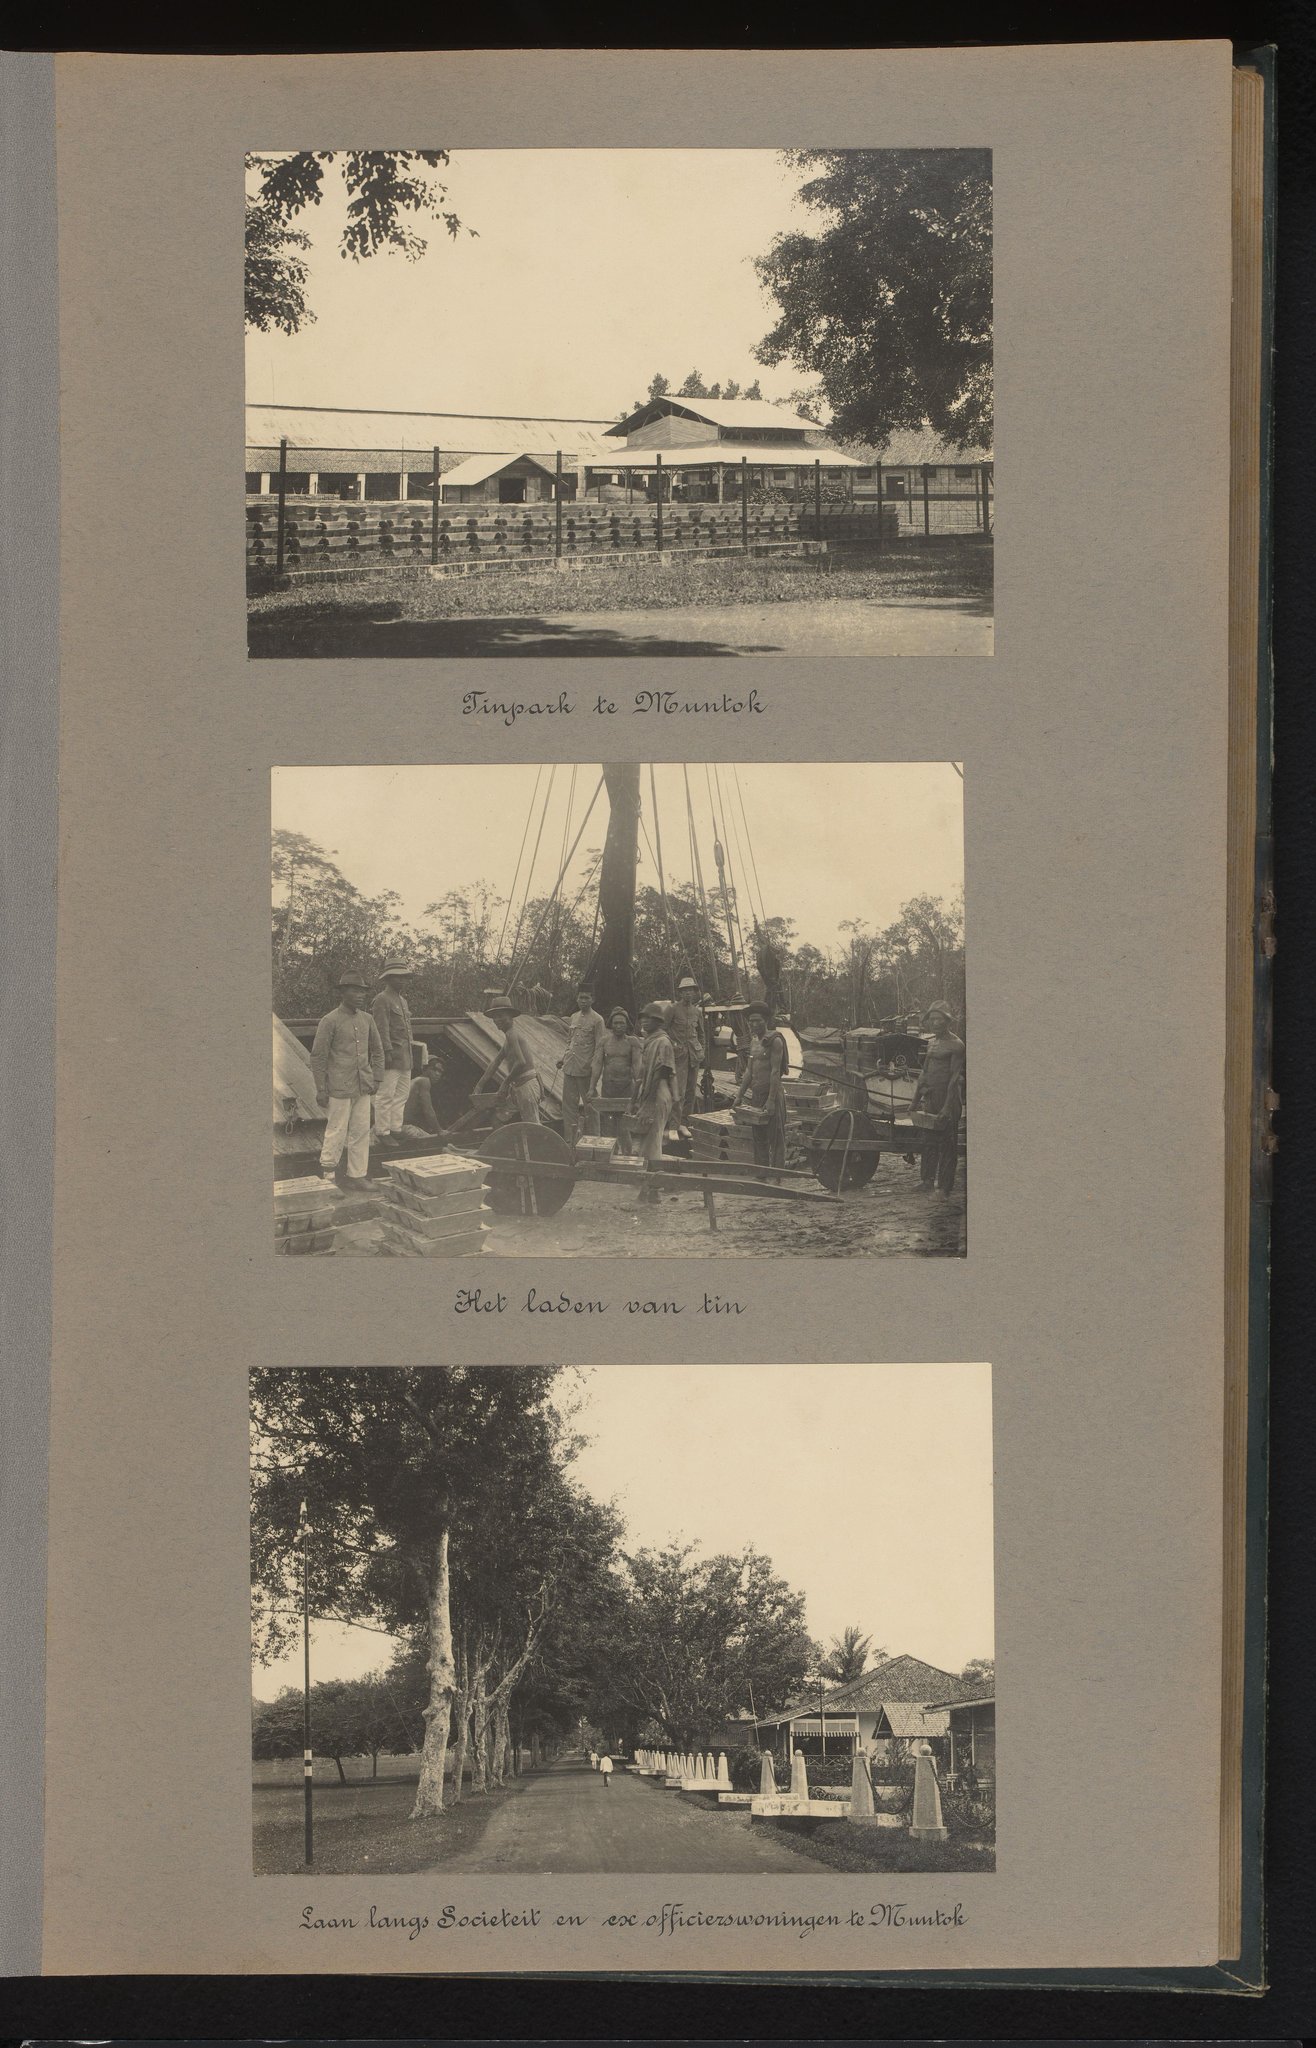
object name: photograph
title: Gebouwen en werk van de Banka-tinwinning, te Muntok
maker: Anonymous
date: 1914-1919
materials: cardboard, photographic support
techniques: gelatin silver print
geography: bangka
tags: robert julius boers, colonial system, club, meeting place, mining, exterior of industrial structures, factories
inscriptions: inscription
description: Albumblad met drie foto's van gebouwen en van het laden van tin, van de Banka-tinwinning te Muntok. Onderdeel van het fotoalbum aangeboden aan Robert Julius Boers bij zijn vertrek naar Nederland in 1919 door het personeel van de Banka-tinwinning.